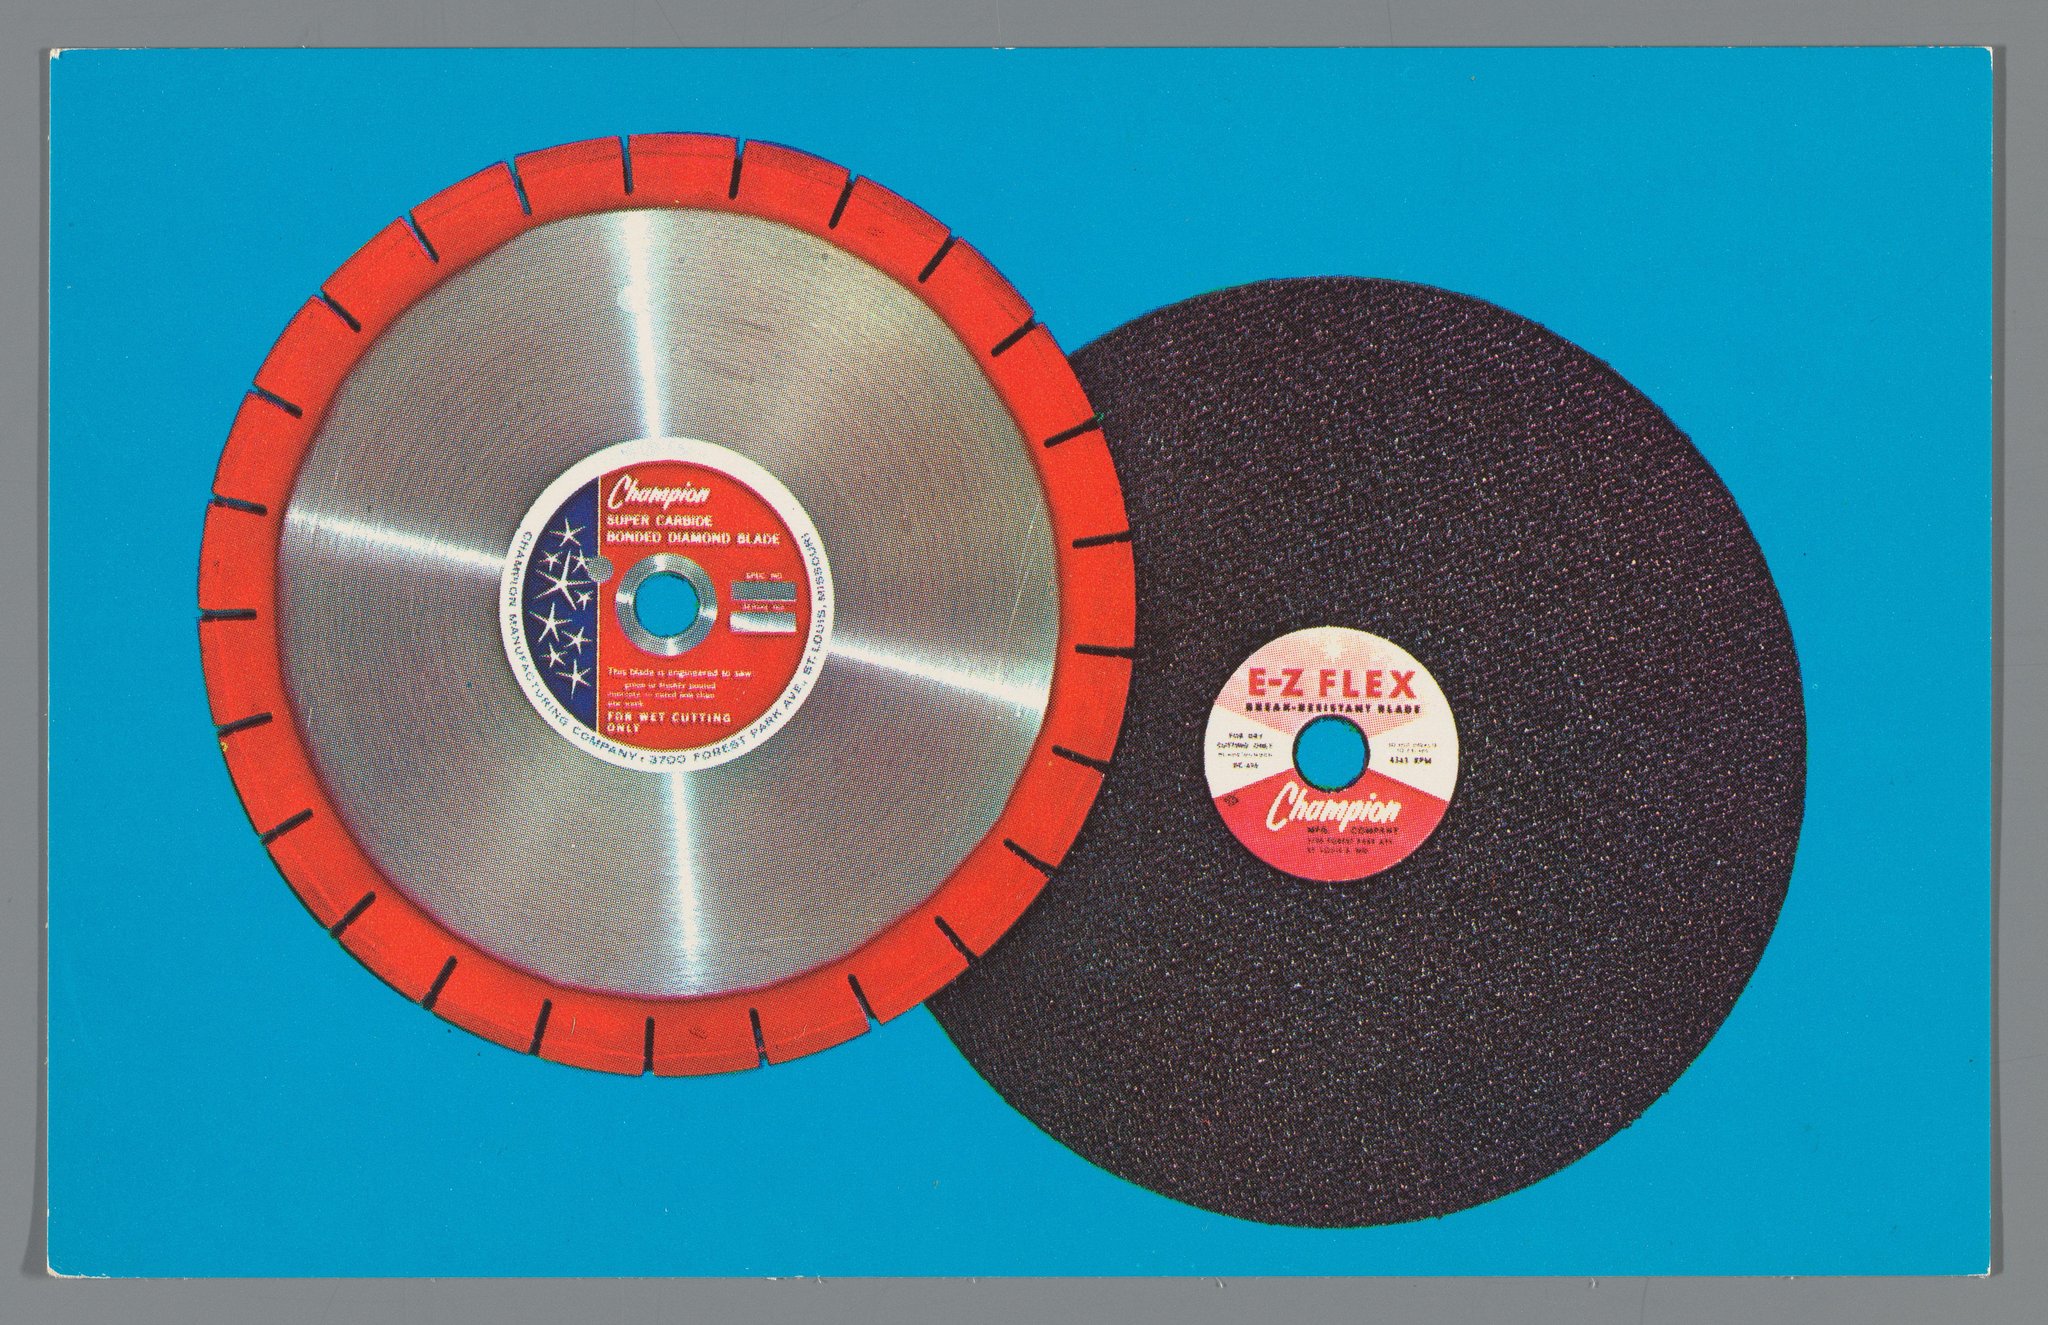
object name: ansichtkaart, prentbriefkaart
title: Reclamefoto voor zagen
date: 1950-1970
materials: cardboard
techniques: four-color autotype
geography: boston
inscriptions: inscription: ‘[…] TINGSTEN’s CARBIDE BONDED / DIAMOND BLADES / […] // Plastichrome ® by COLOURPICTURE PUBLISHERS, INC., Boston 30, Mass. U.S.A. / P50682’